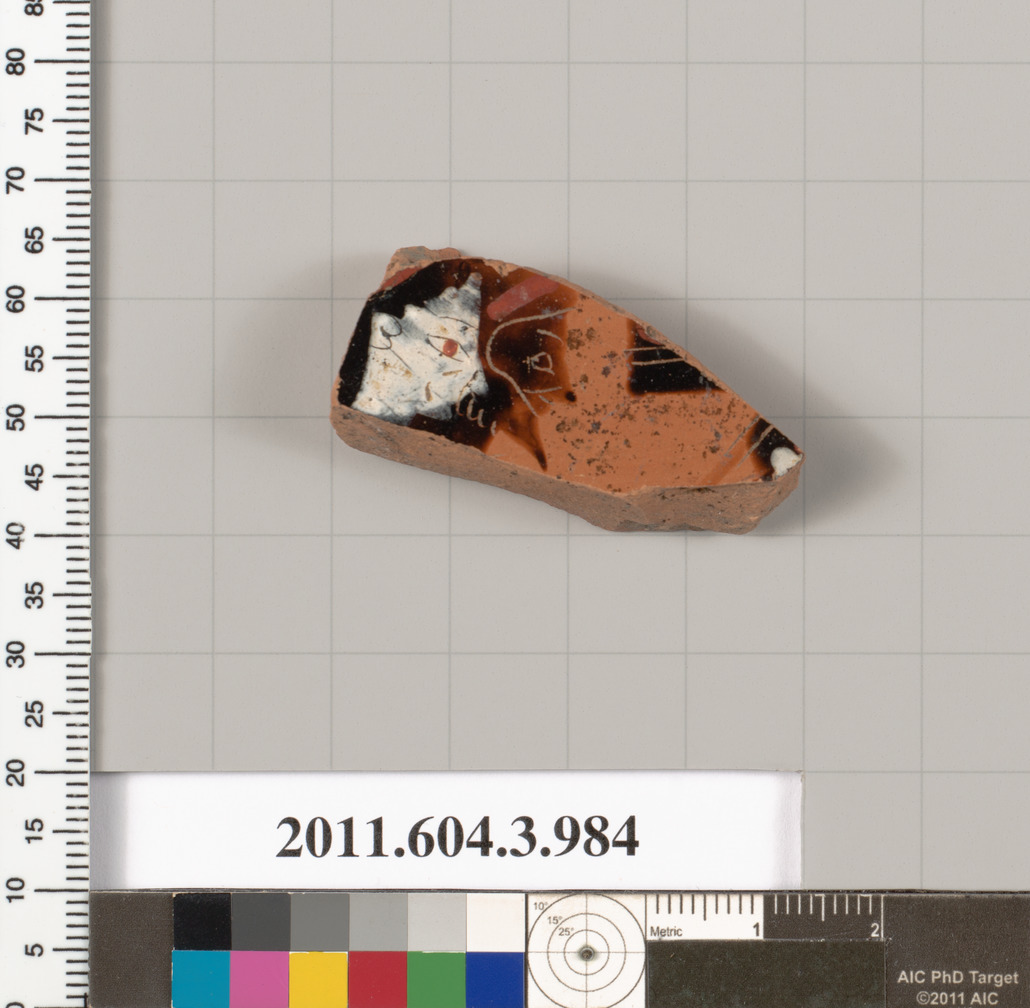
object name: lekanis lid fragment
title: Terracotta fragment of a lekanis lid (covered dish)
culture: greek, attic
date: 575-551 BCE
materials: terracotta